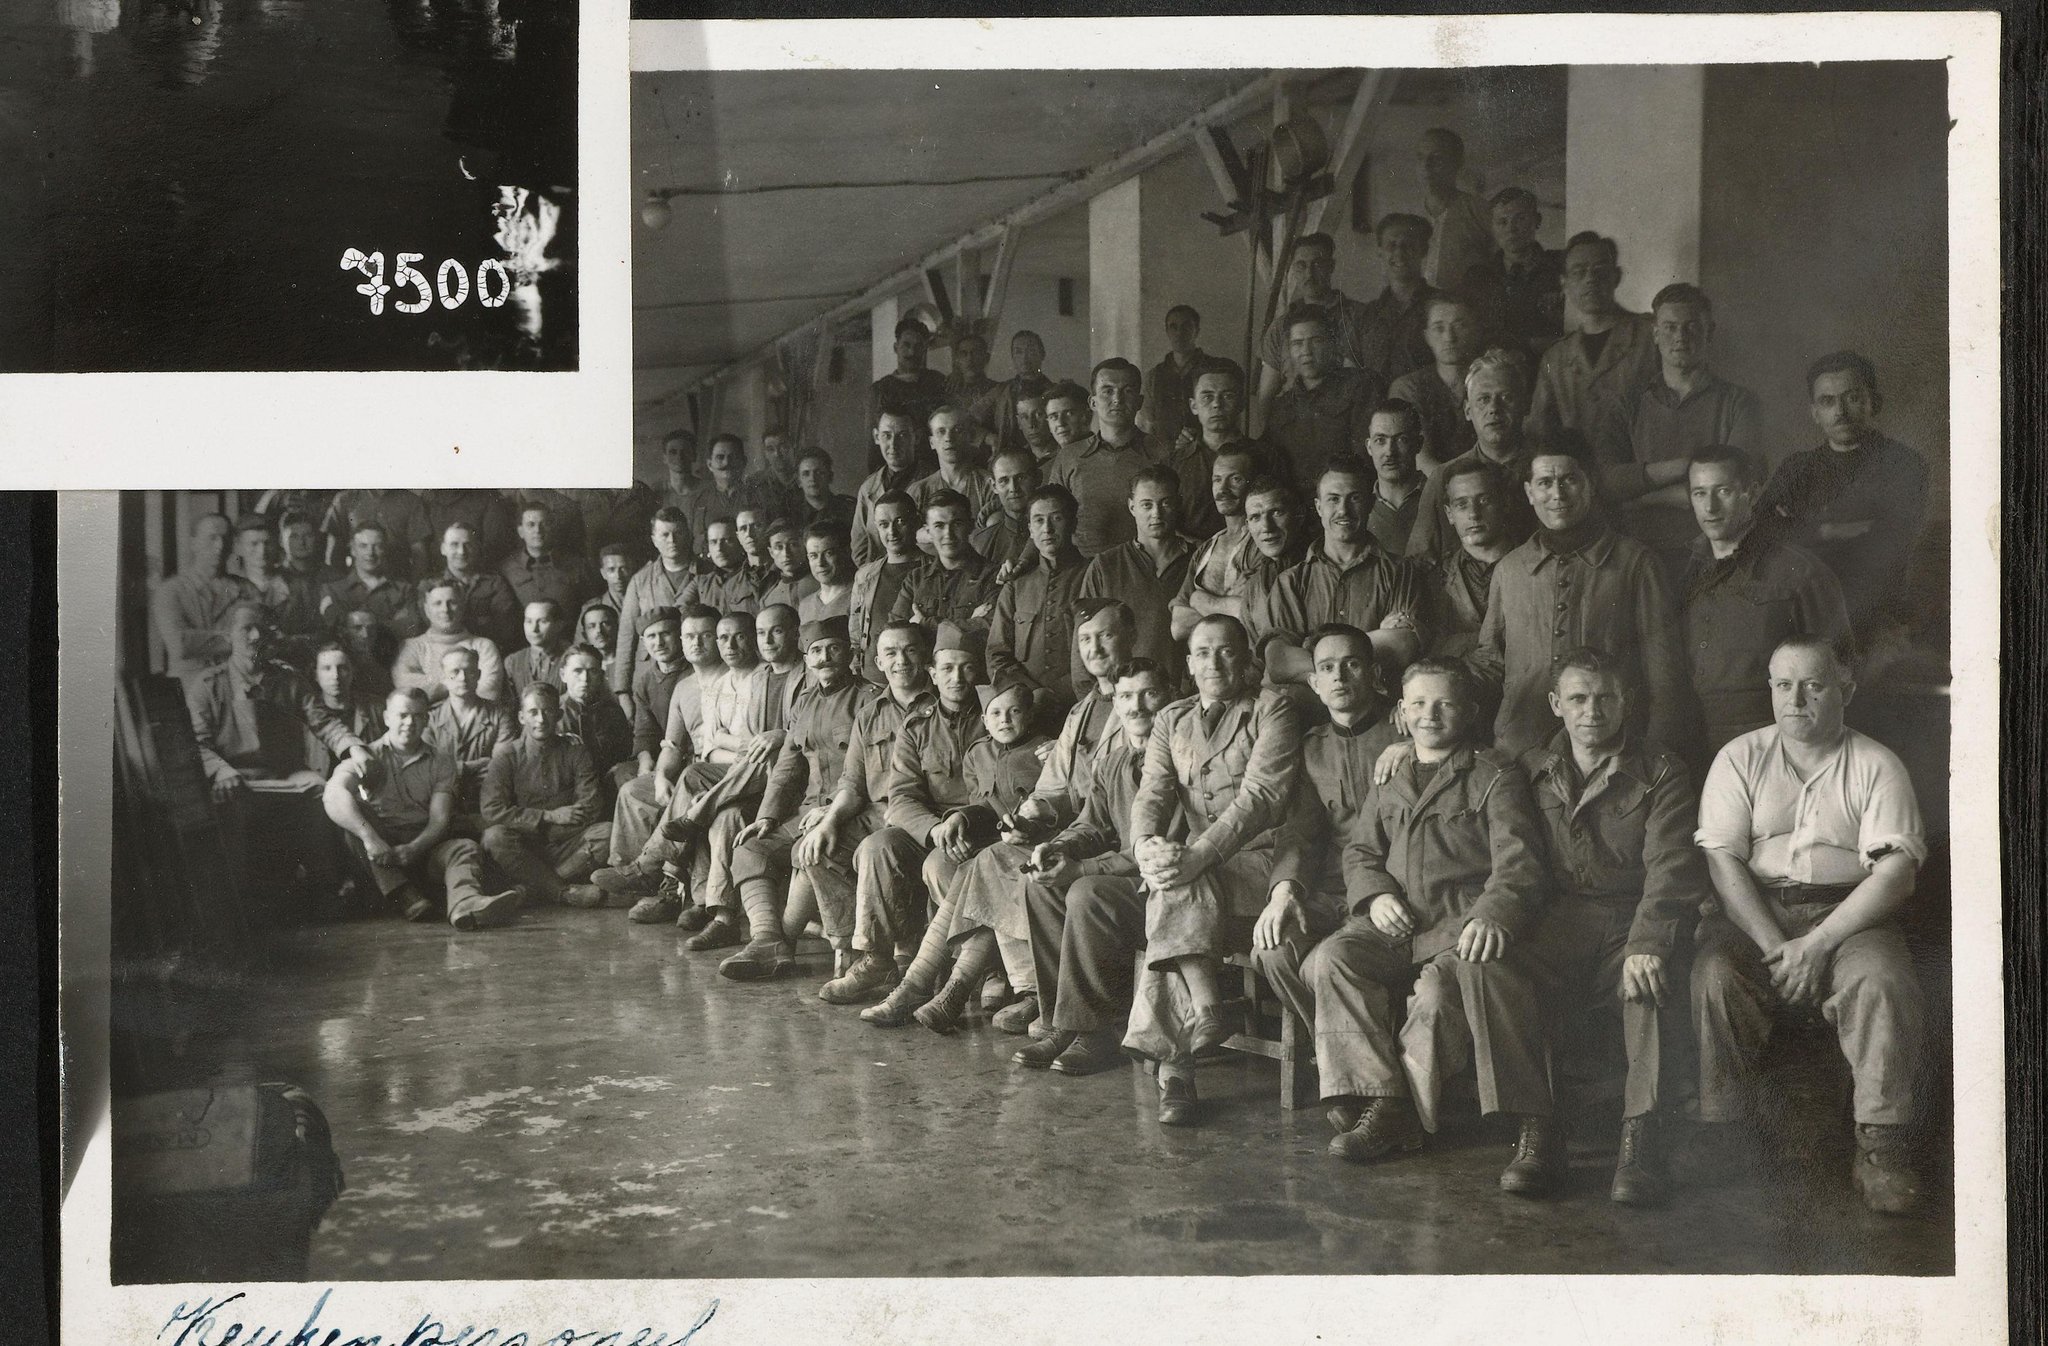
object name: album leaf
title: Keuken / Keukenpersoneel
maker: dick w.b. van maarseveen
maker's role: fotograaf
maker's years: 1905-1990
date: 1943-1945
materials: cardboard, photographic support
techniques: gelatin silver print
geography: muhlberg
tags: the hague, dick w.b. van maarseveen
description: Albumblad met twee foto's van de gevangenen werkend in de keuken en een groepsportret van het keukenpersoneel. Onderdeel van een fotoalbum met foto's door Dick van Maarseveen van het krijgsgevangenenkamp Stalag IV B in Mühlberg in de periode 1943-1945.